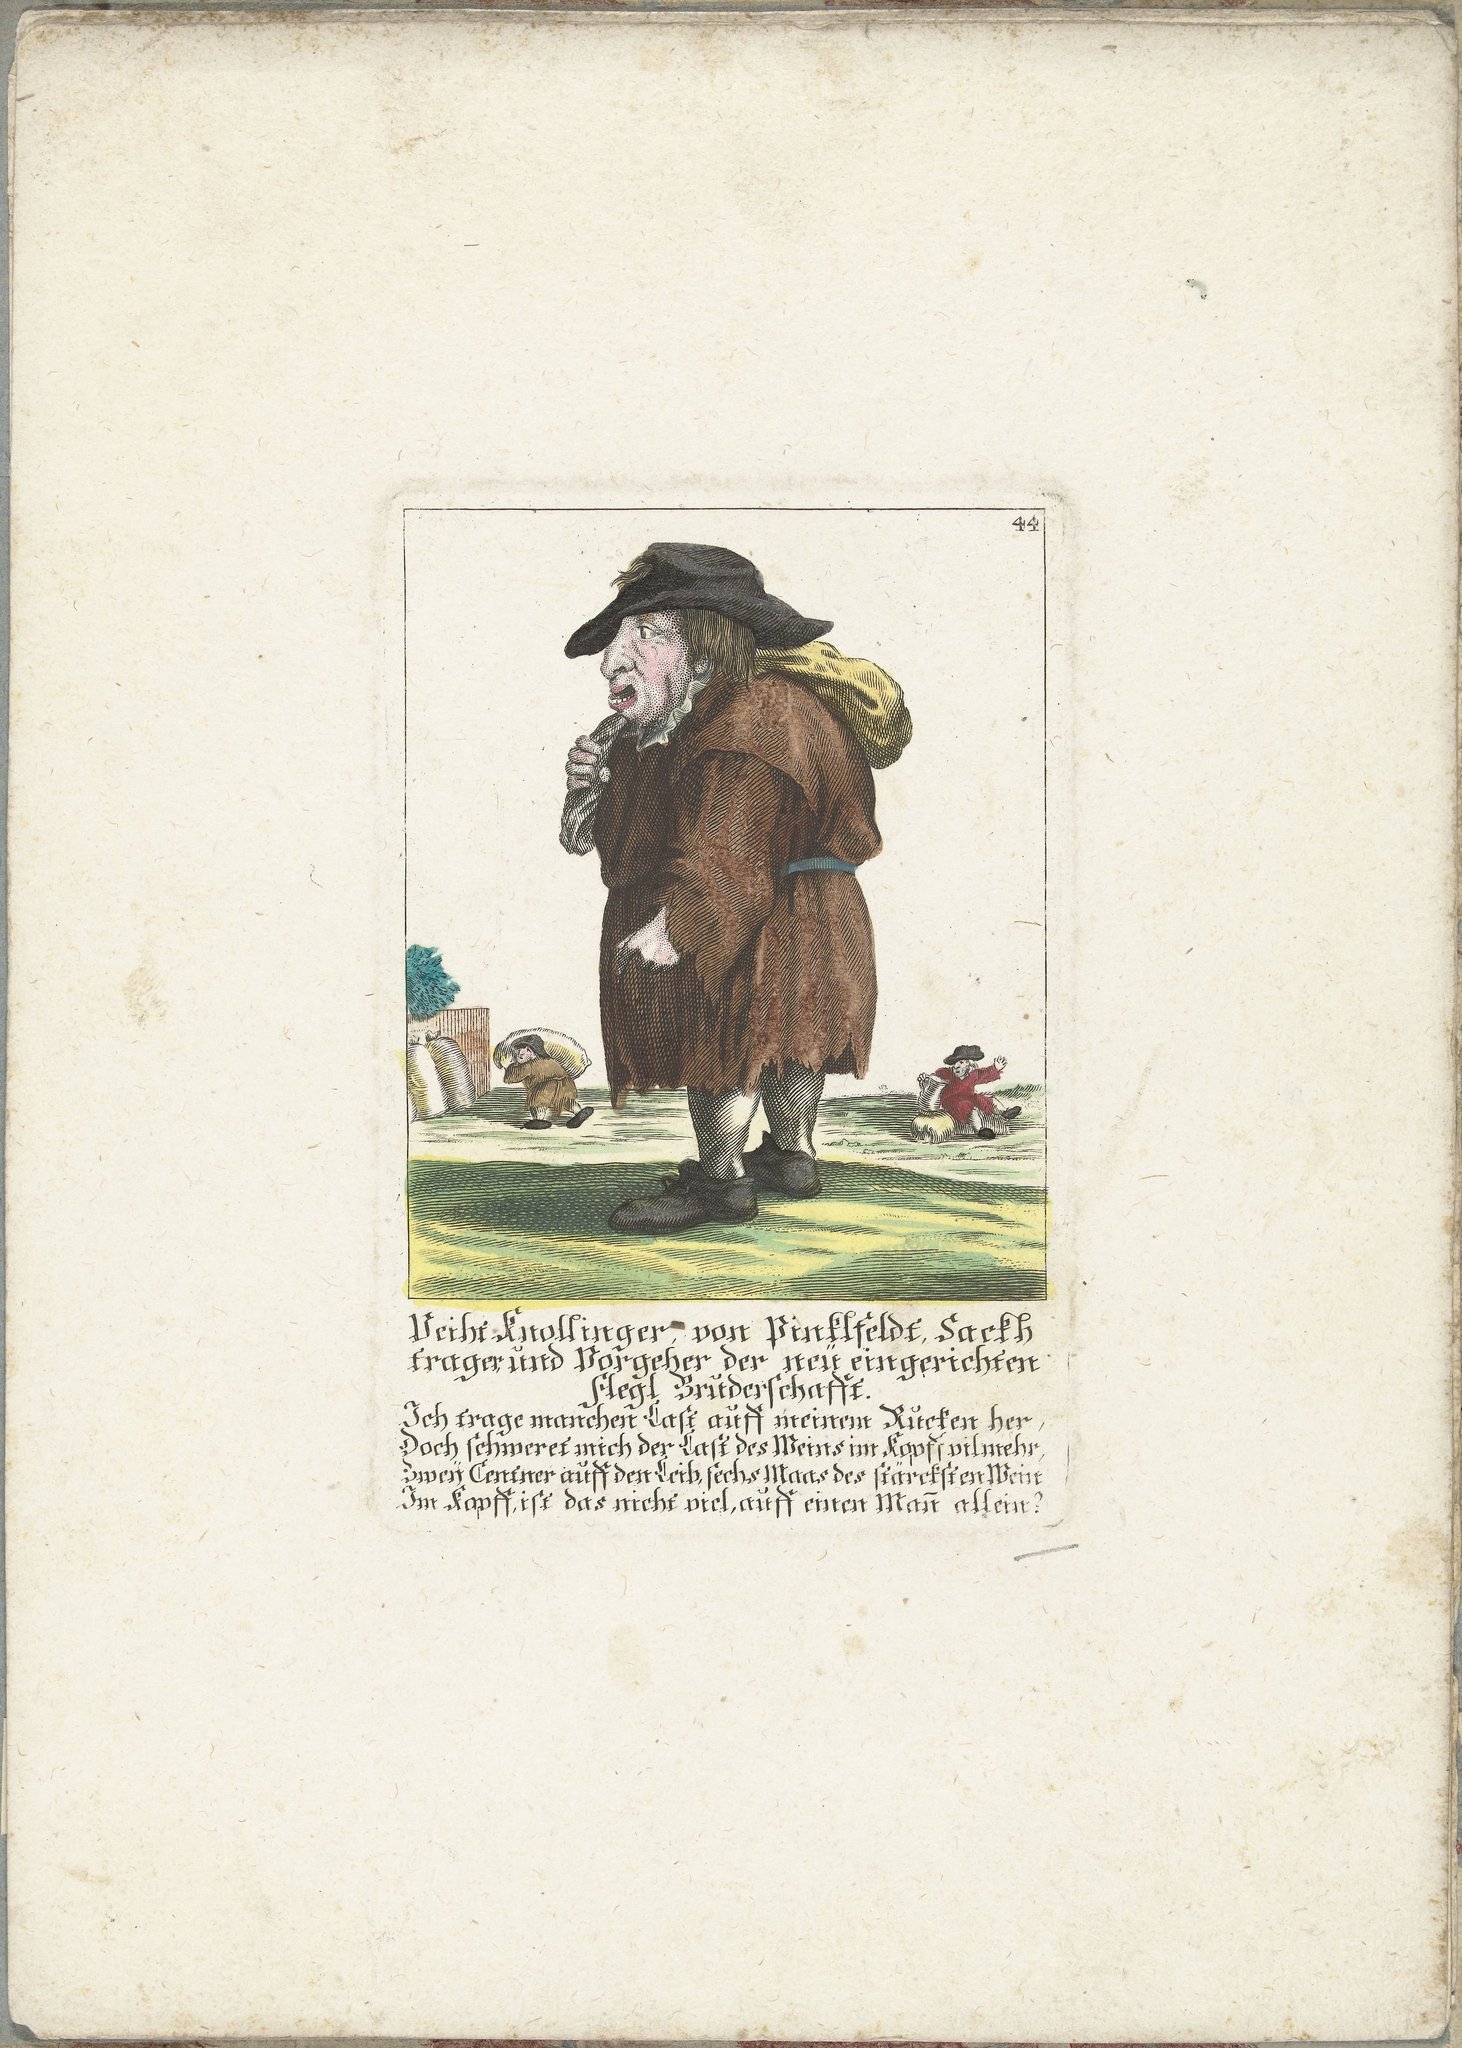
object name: caricature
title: Il Callotto resurcitato oder Neu eingerichtes Zwerchen Cabinet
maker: martin engelbrecht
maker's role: print maker, publisher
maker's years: 1684-1756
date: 1705-1715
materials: paper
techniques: engraving, hand coloring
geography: augsburg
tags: caricatures (human types), little people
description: De kleine mens Veith Knollinger von Pinklfeldt, zakkendrager. In het onderschrift onder de titel een vierregelig vers in het Duits. Genummerd rechtsboven: 44. Onderdeel van een losbladige uitgave uit ca. 1710 van een serie karikaturen van kleine mensen, bekend als Het Dwergentooneel.